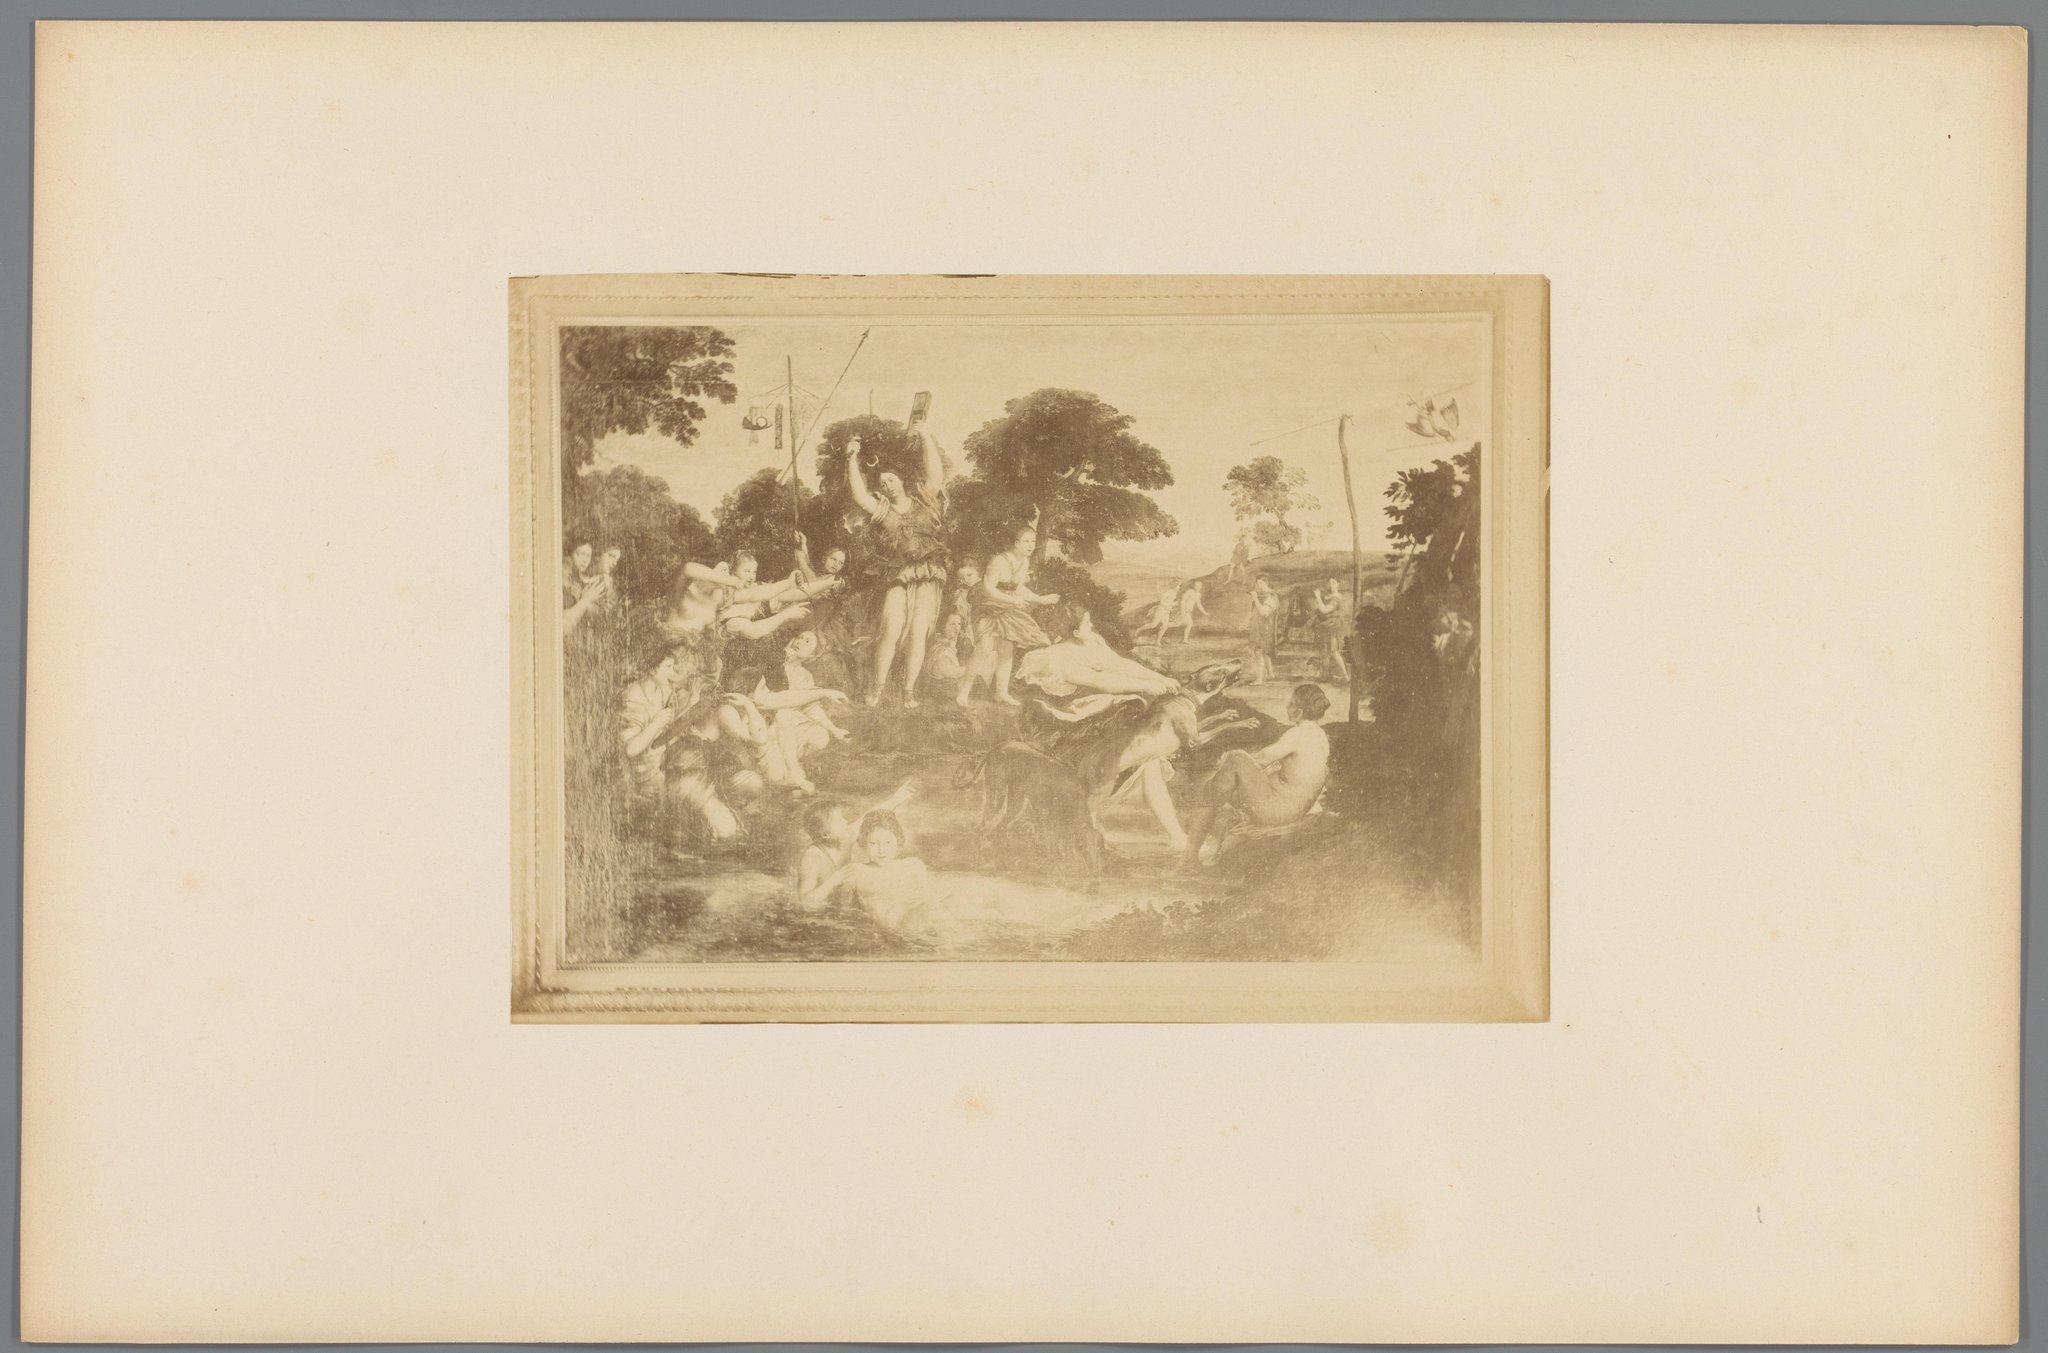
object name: photograph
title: Fotoreproductie van een schilderij voorstellende een jachttafereel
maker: Anonymous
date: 1851-1900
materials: cardboard, paper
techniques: albumen print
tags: bird hunting, archer's weapons: bow, picture, painting